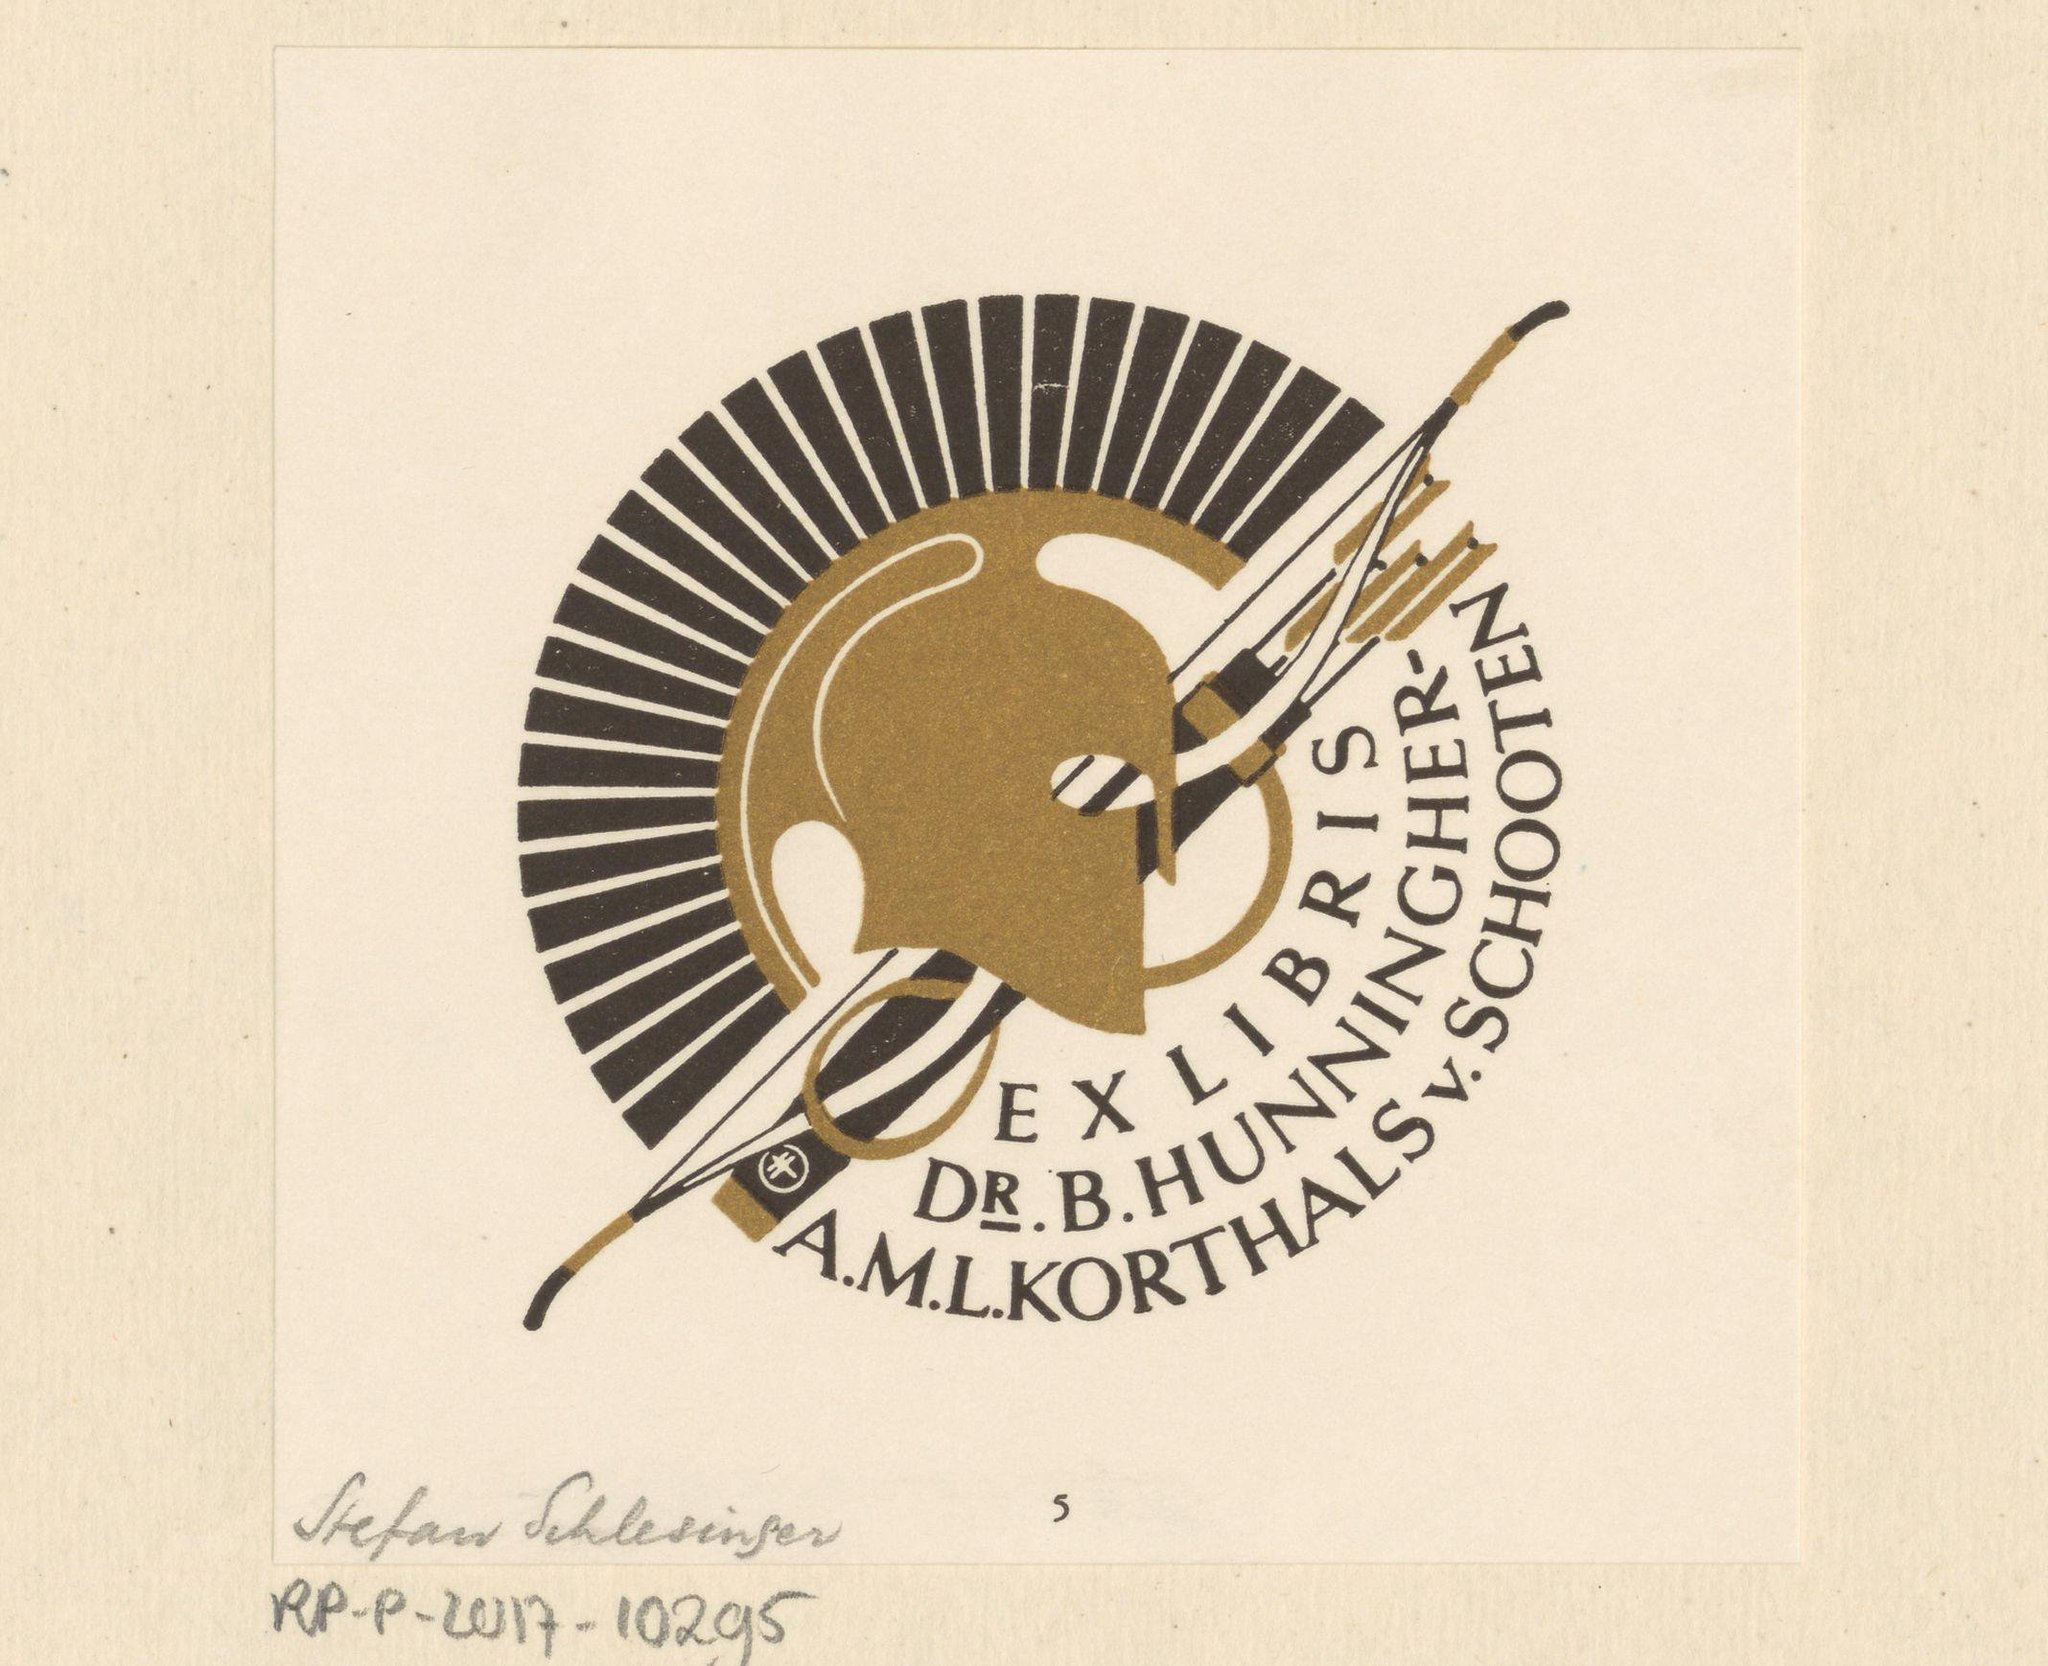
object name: bookplate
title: Ex libris van Benjamin Hunningher en Anna Korthals van Schooten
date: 1906-1944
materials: paper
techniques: printing block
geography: netherlands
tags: helmet, archer's weapons